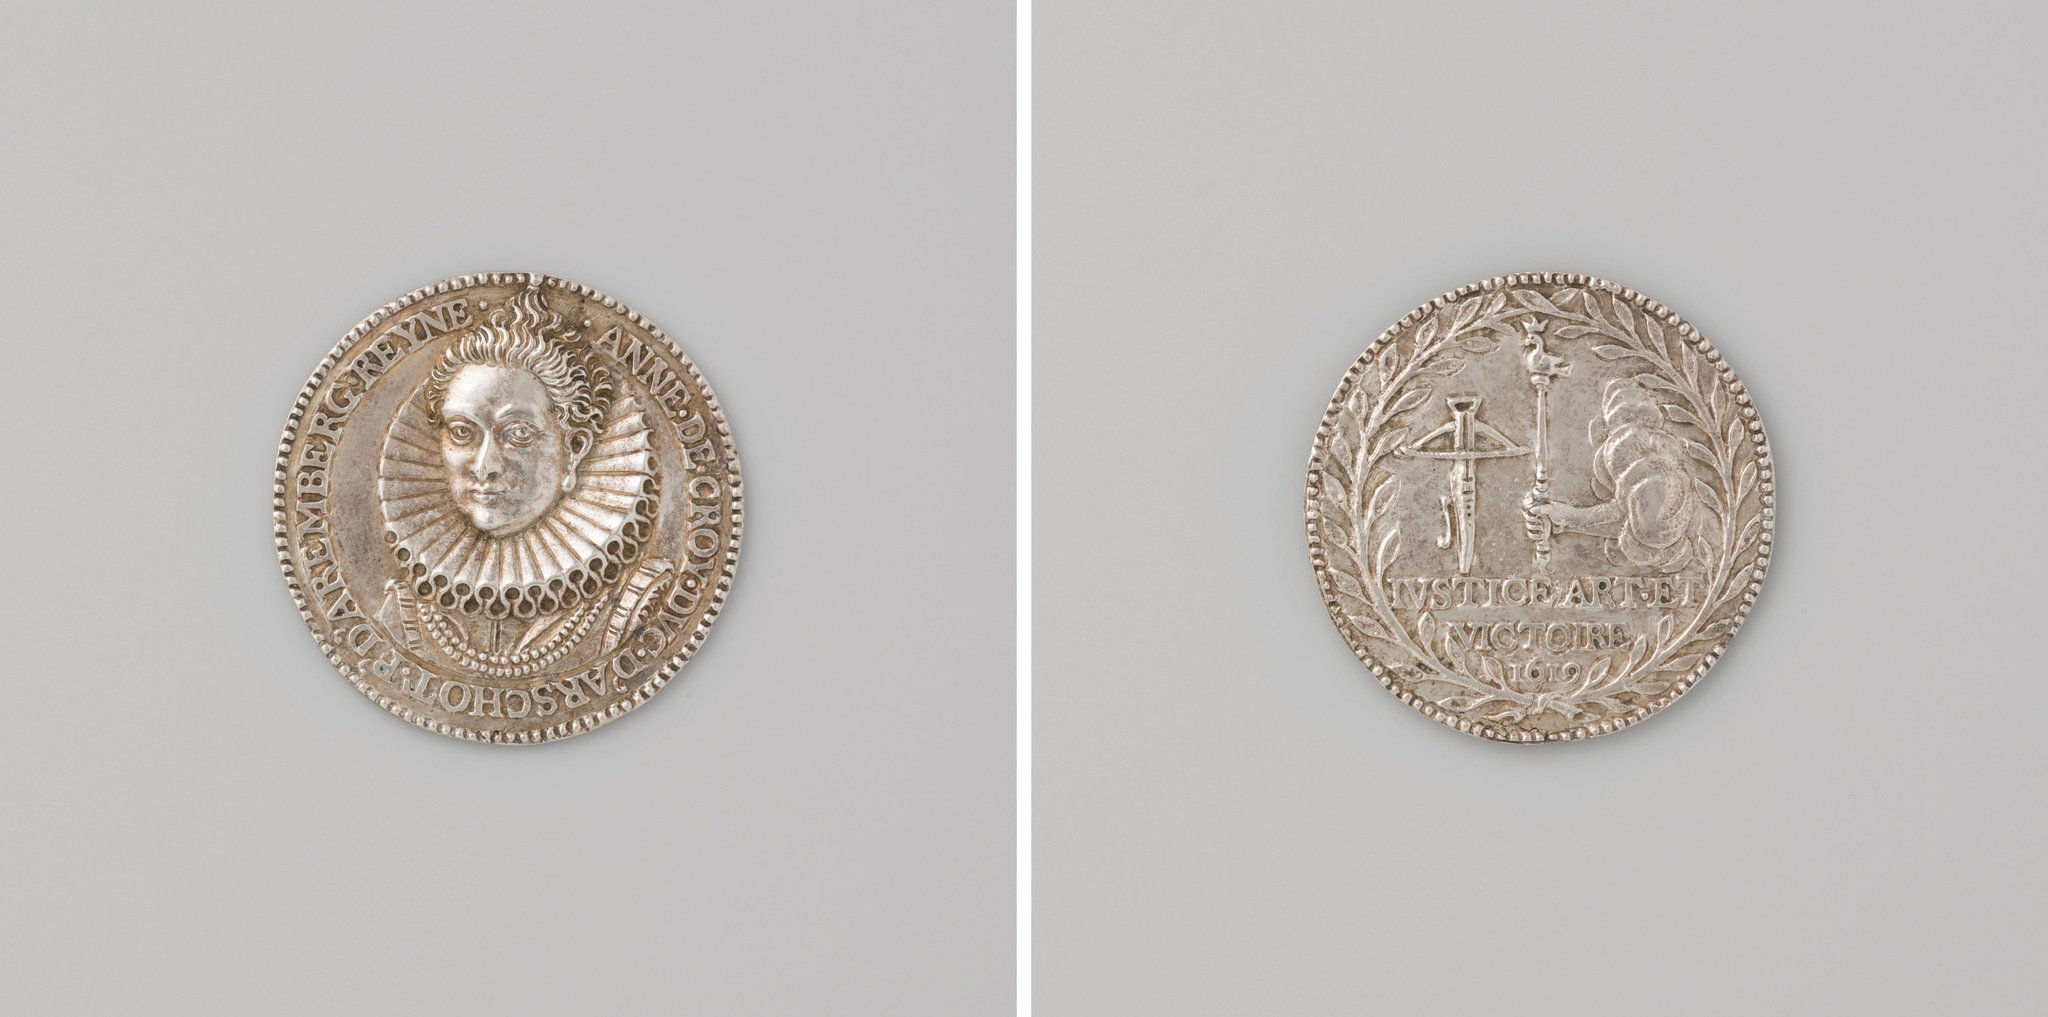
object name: history medal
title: Het treffen van de vogel door Anna van Croy, hertogin van Aarschot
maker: denis waterloos (ii)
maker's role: medailleur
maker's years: 1628-1715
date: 1651-1707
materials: silver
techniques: casting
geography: brussels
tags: anna van croÿ (hertogin van aarschot)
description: Zilveren penning. Voorzijde: borststuk vrouw binnen omschrift. Keerzijde: gekroonde vogel op een staf en voetboog binnen lauwerkrans.